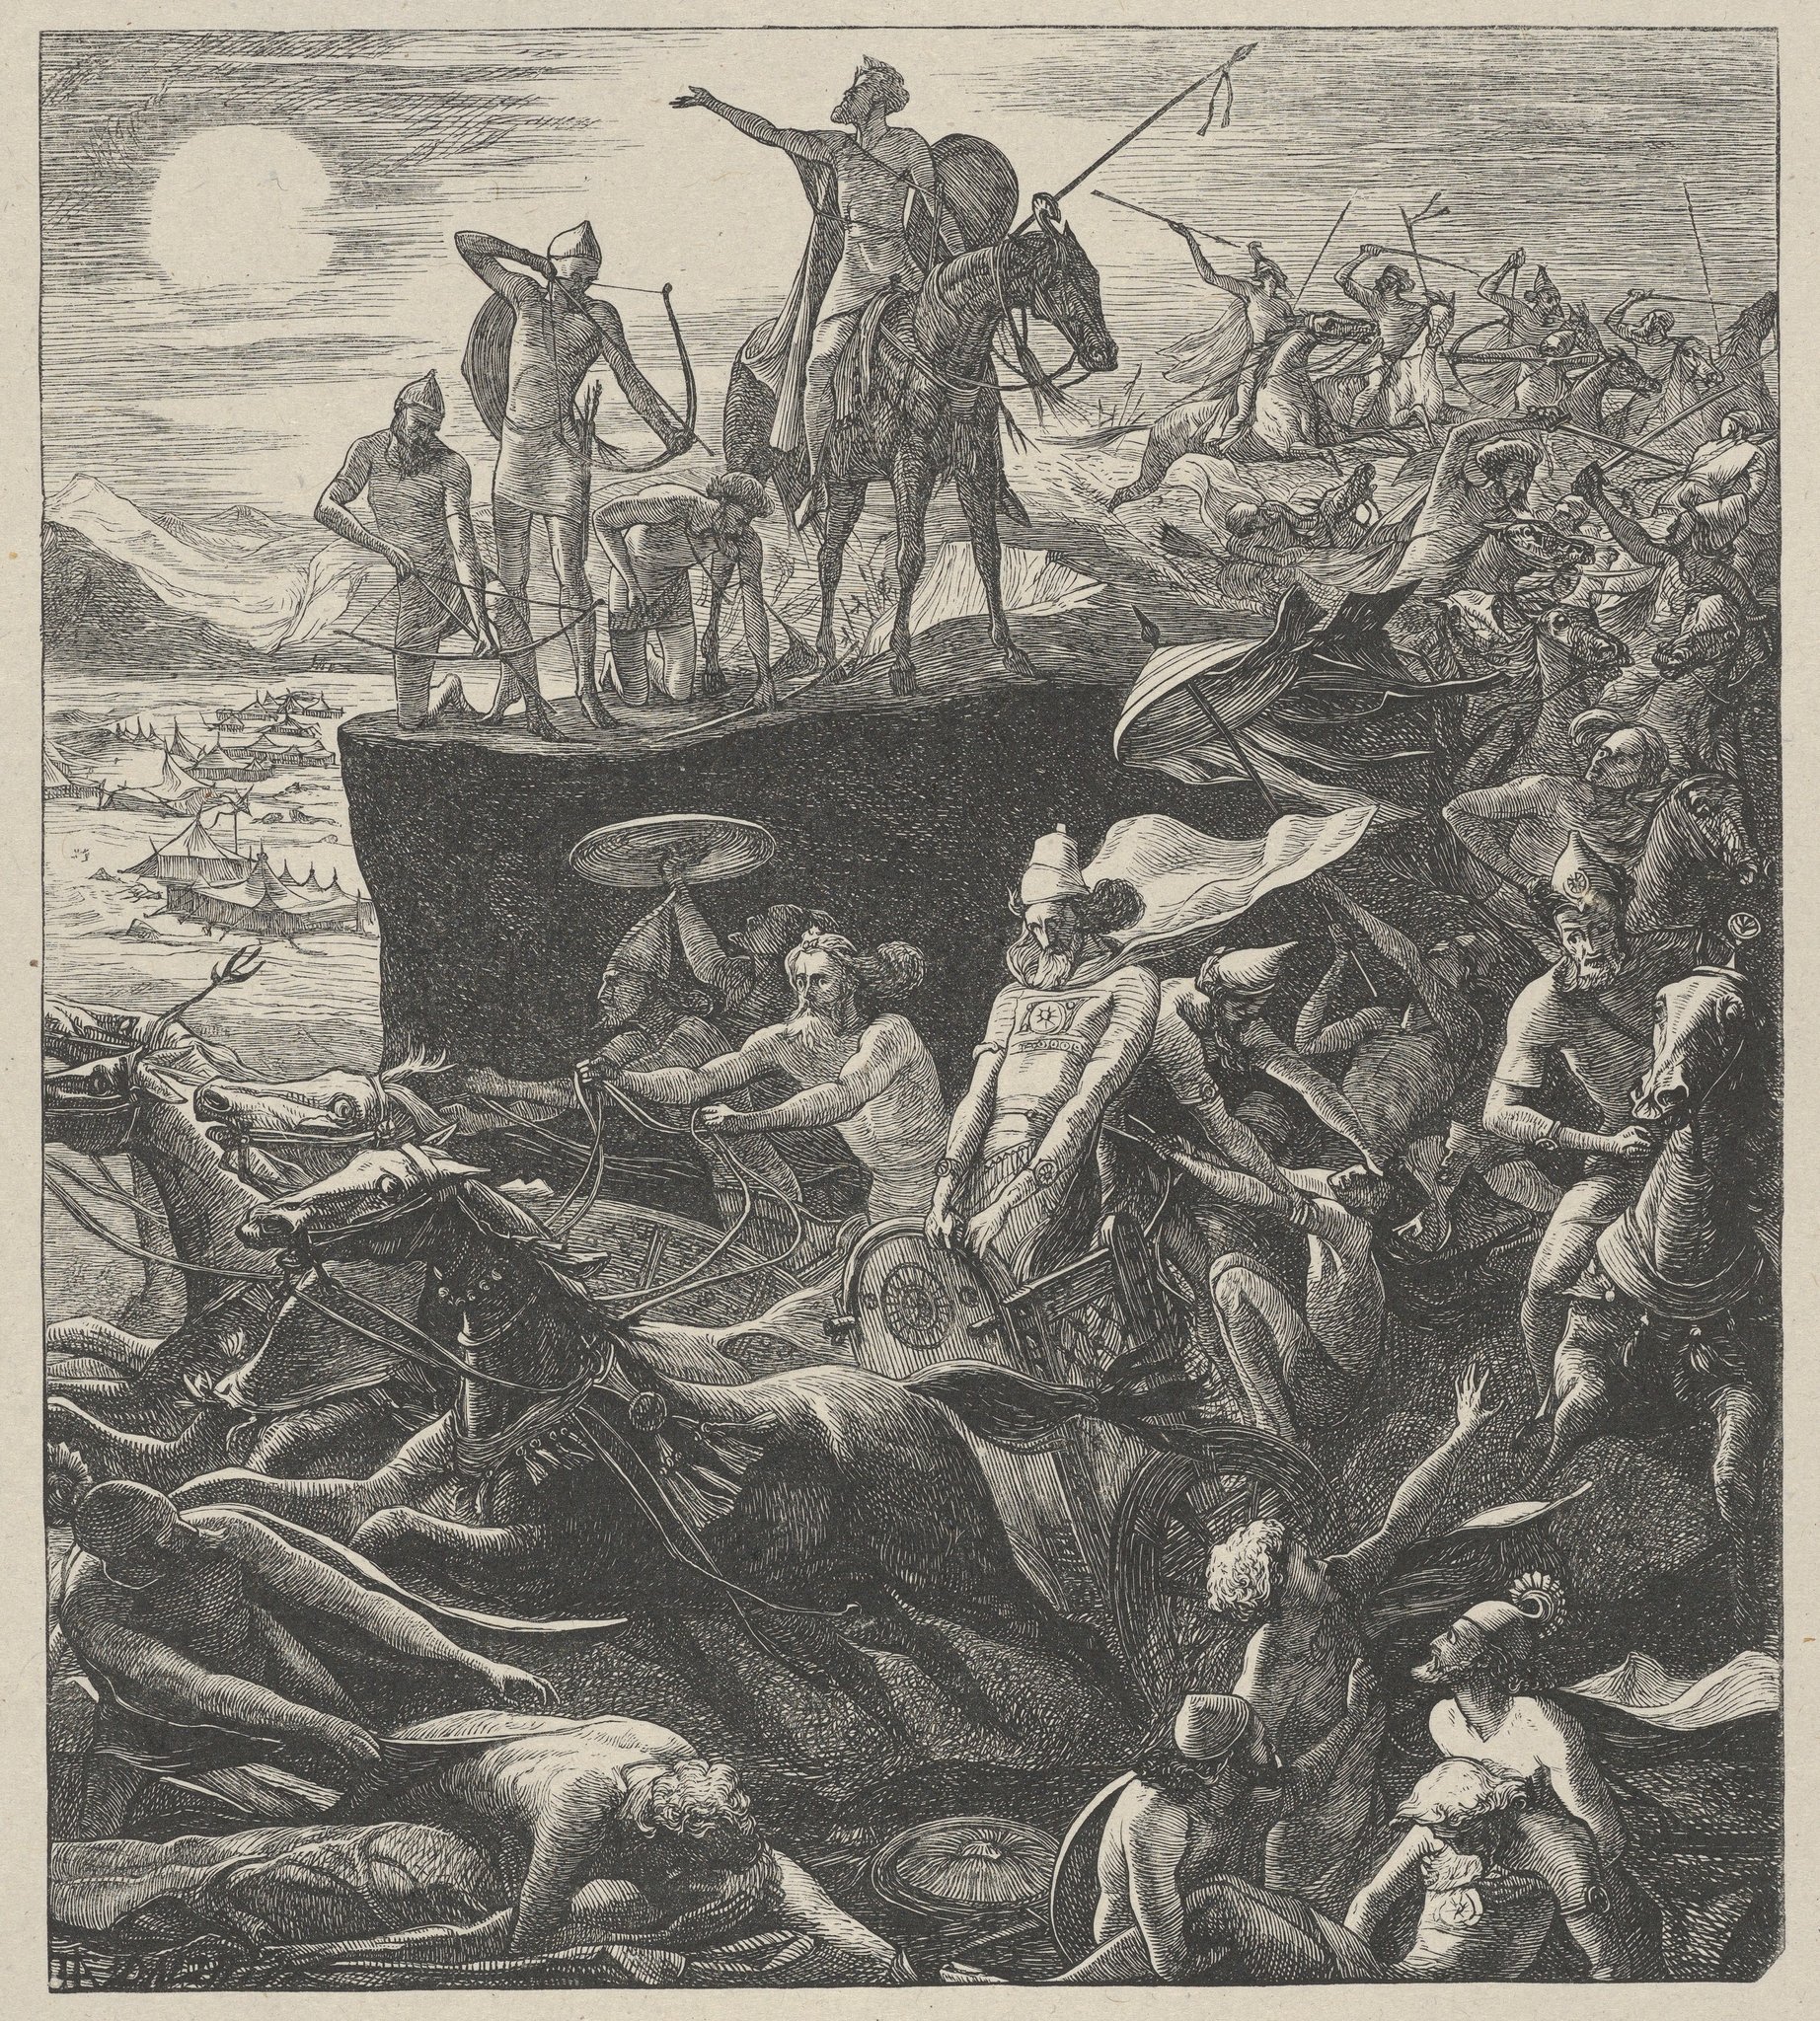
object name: print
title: The Sun and the Moon Stand Still, from "Dalziels' Bible Gallery"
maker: henry hugh armstead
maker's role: artist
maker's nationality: british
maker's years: 1828-1905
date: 1881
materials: paper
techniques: engraving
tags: battles,soldiers,horses,chariots